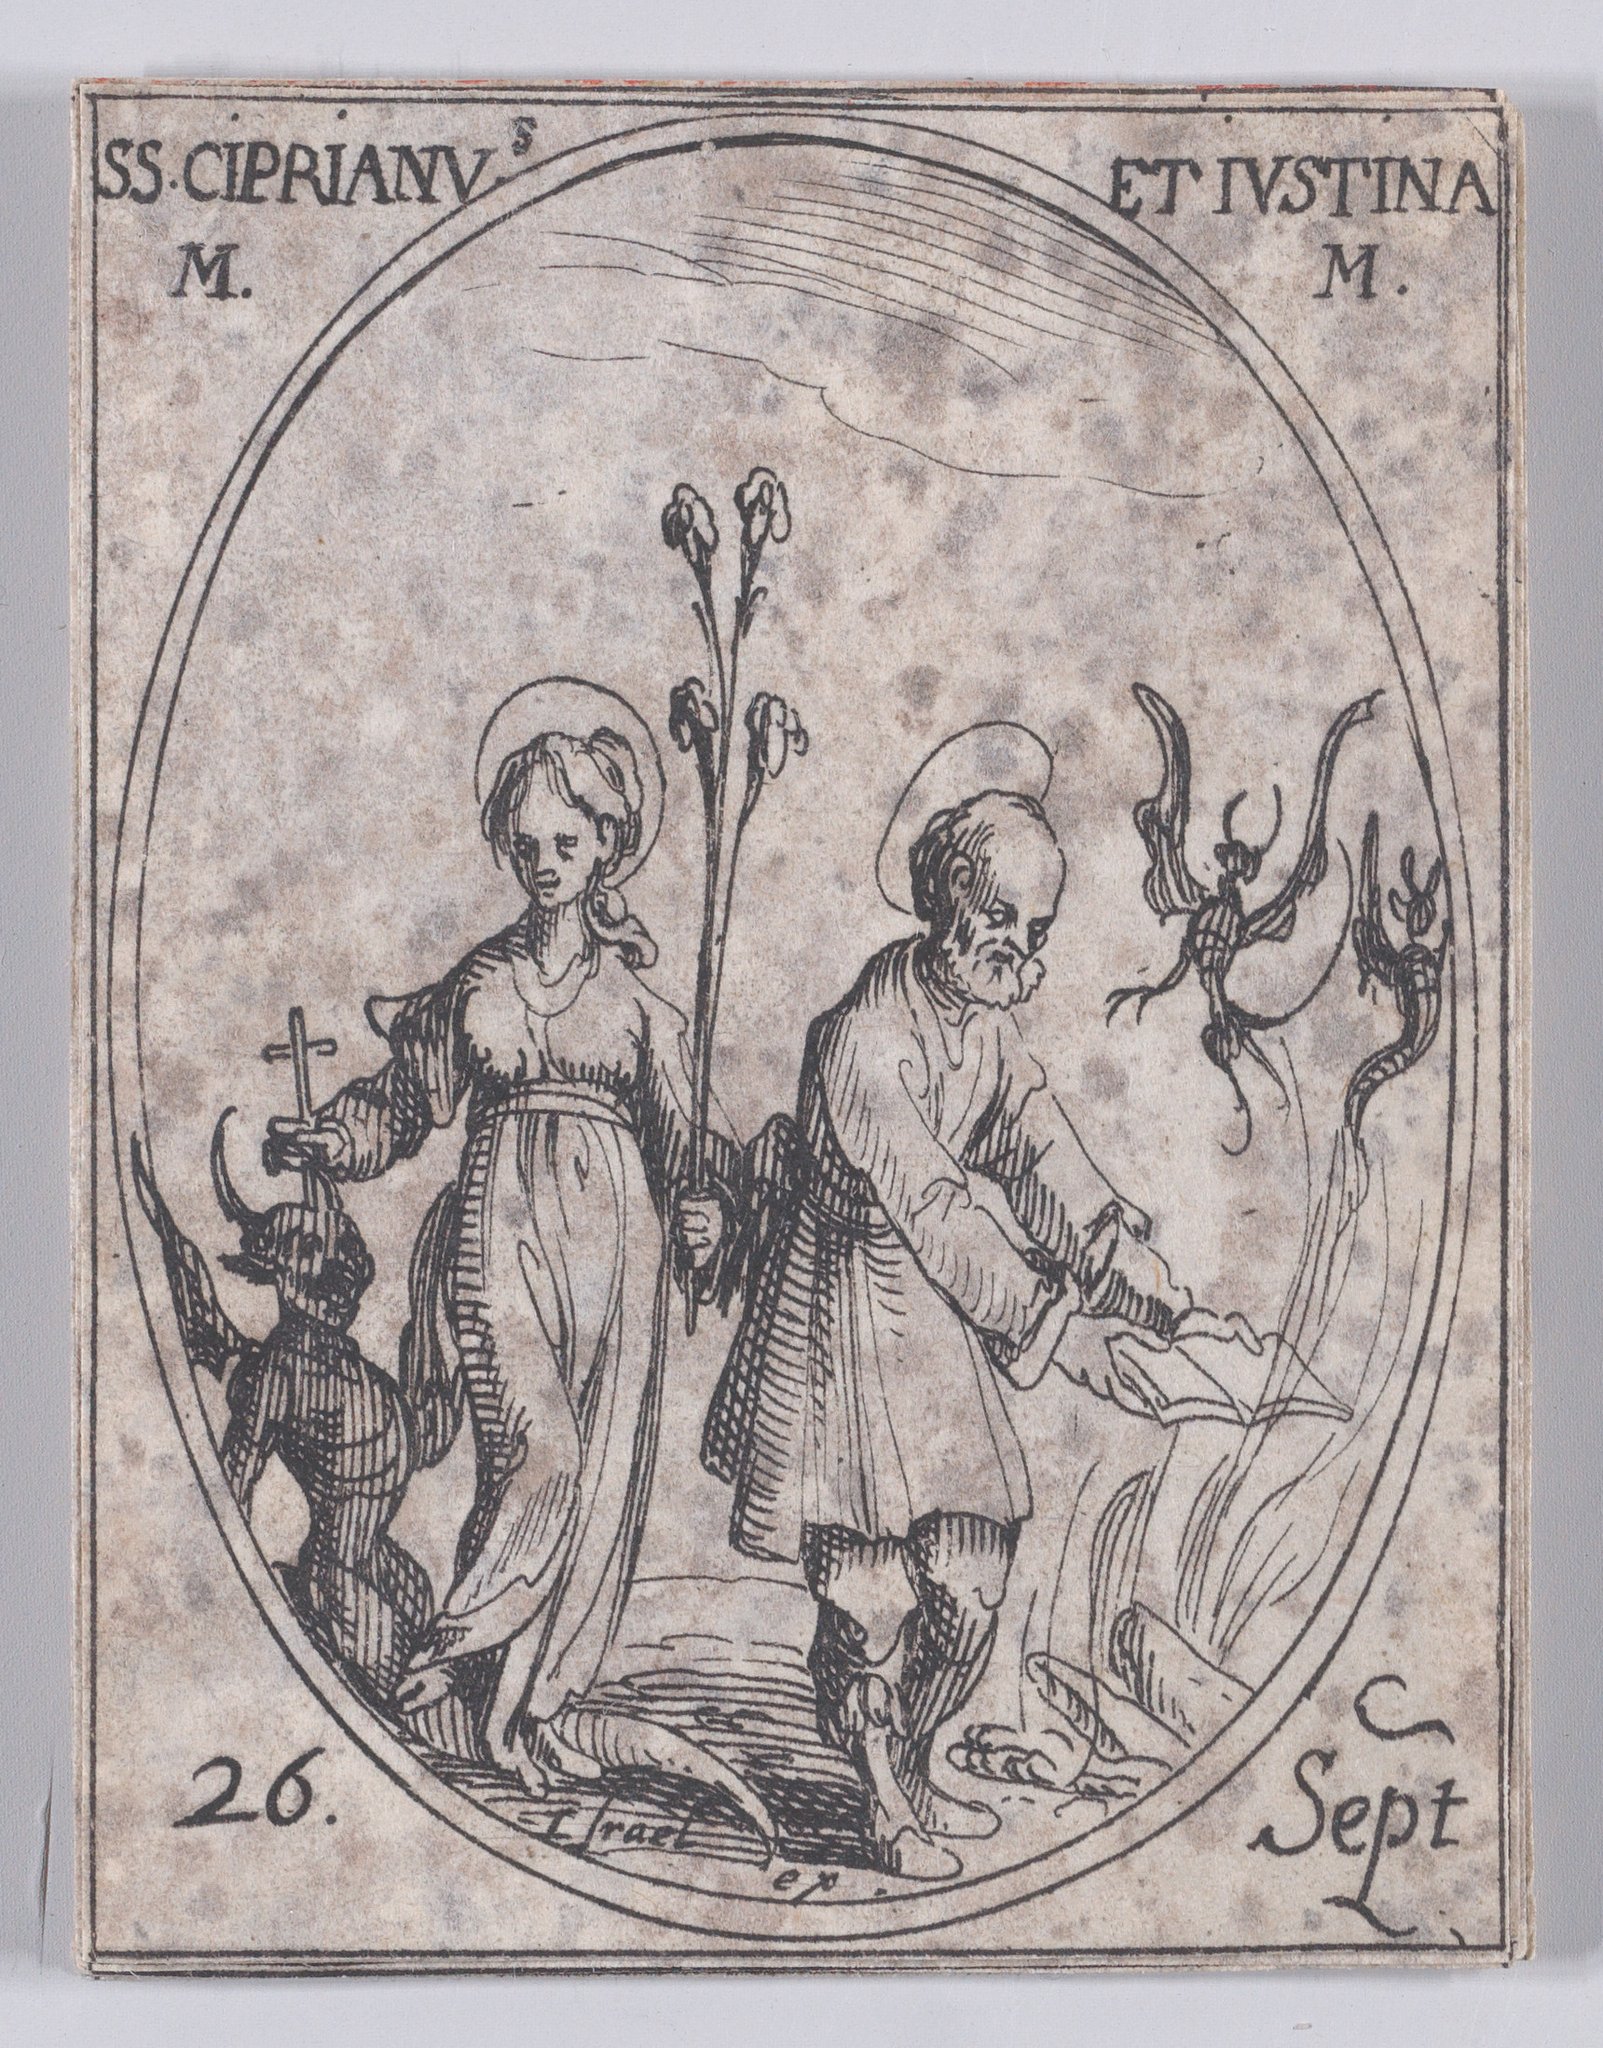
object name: print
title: S. Cyprien et Ste. Justine, martyrs (St. Cyprian and St. Justina, Martyrs), September 26th, from "Les Images De Tous Les Saincts et Saintes de L'Année" (Images of All of the Saints and Religious Events of the Year)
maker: jacques callot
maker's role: artist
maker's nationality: french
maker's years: 1592-1635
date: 1636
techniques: etching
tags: men,women,saints